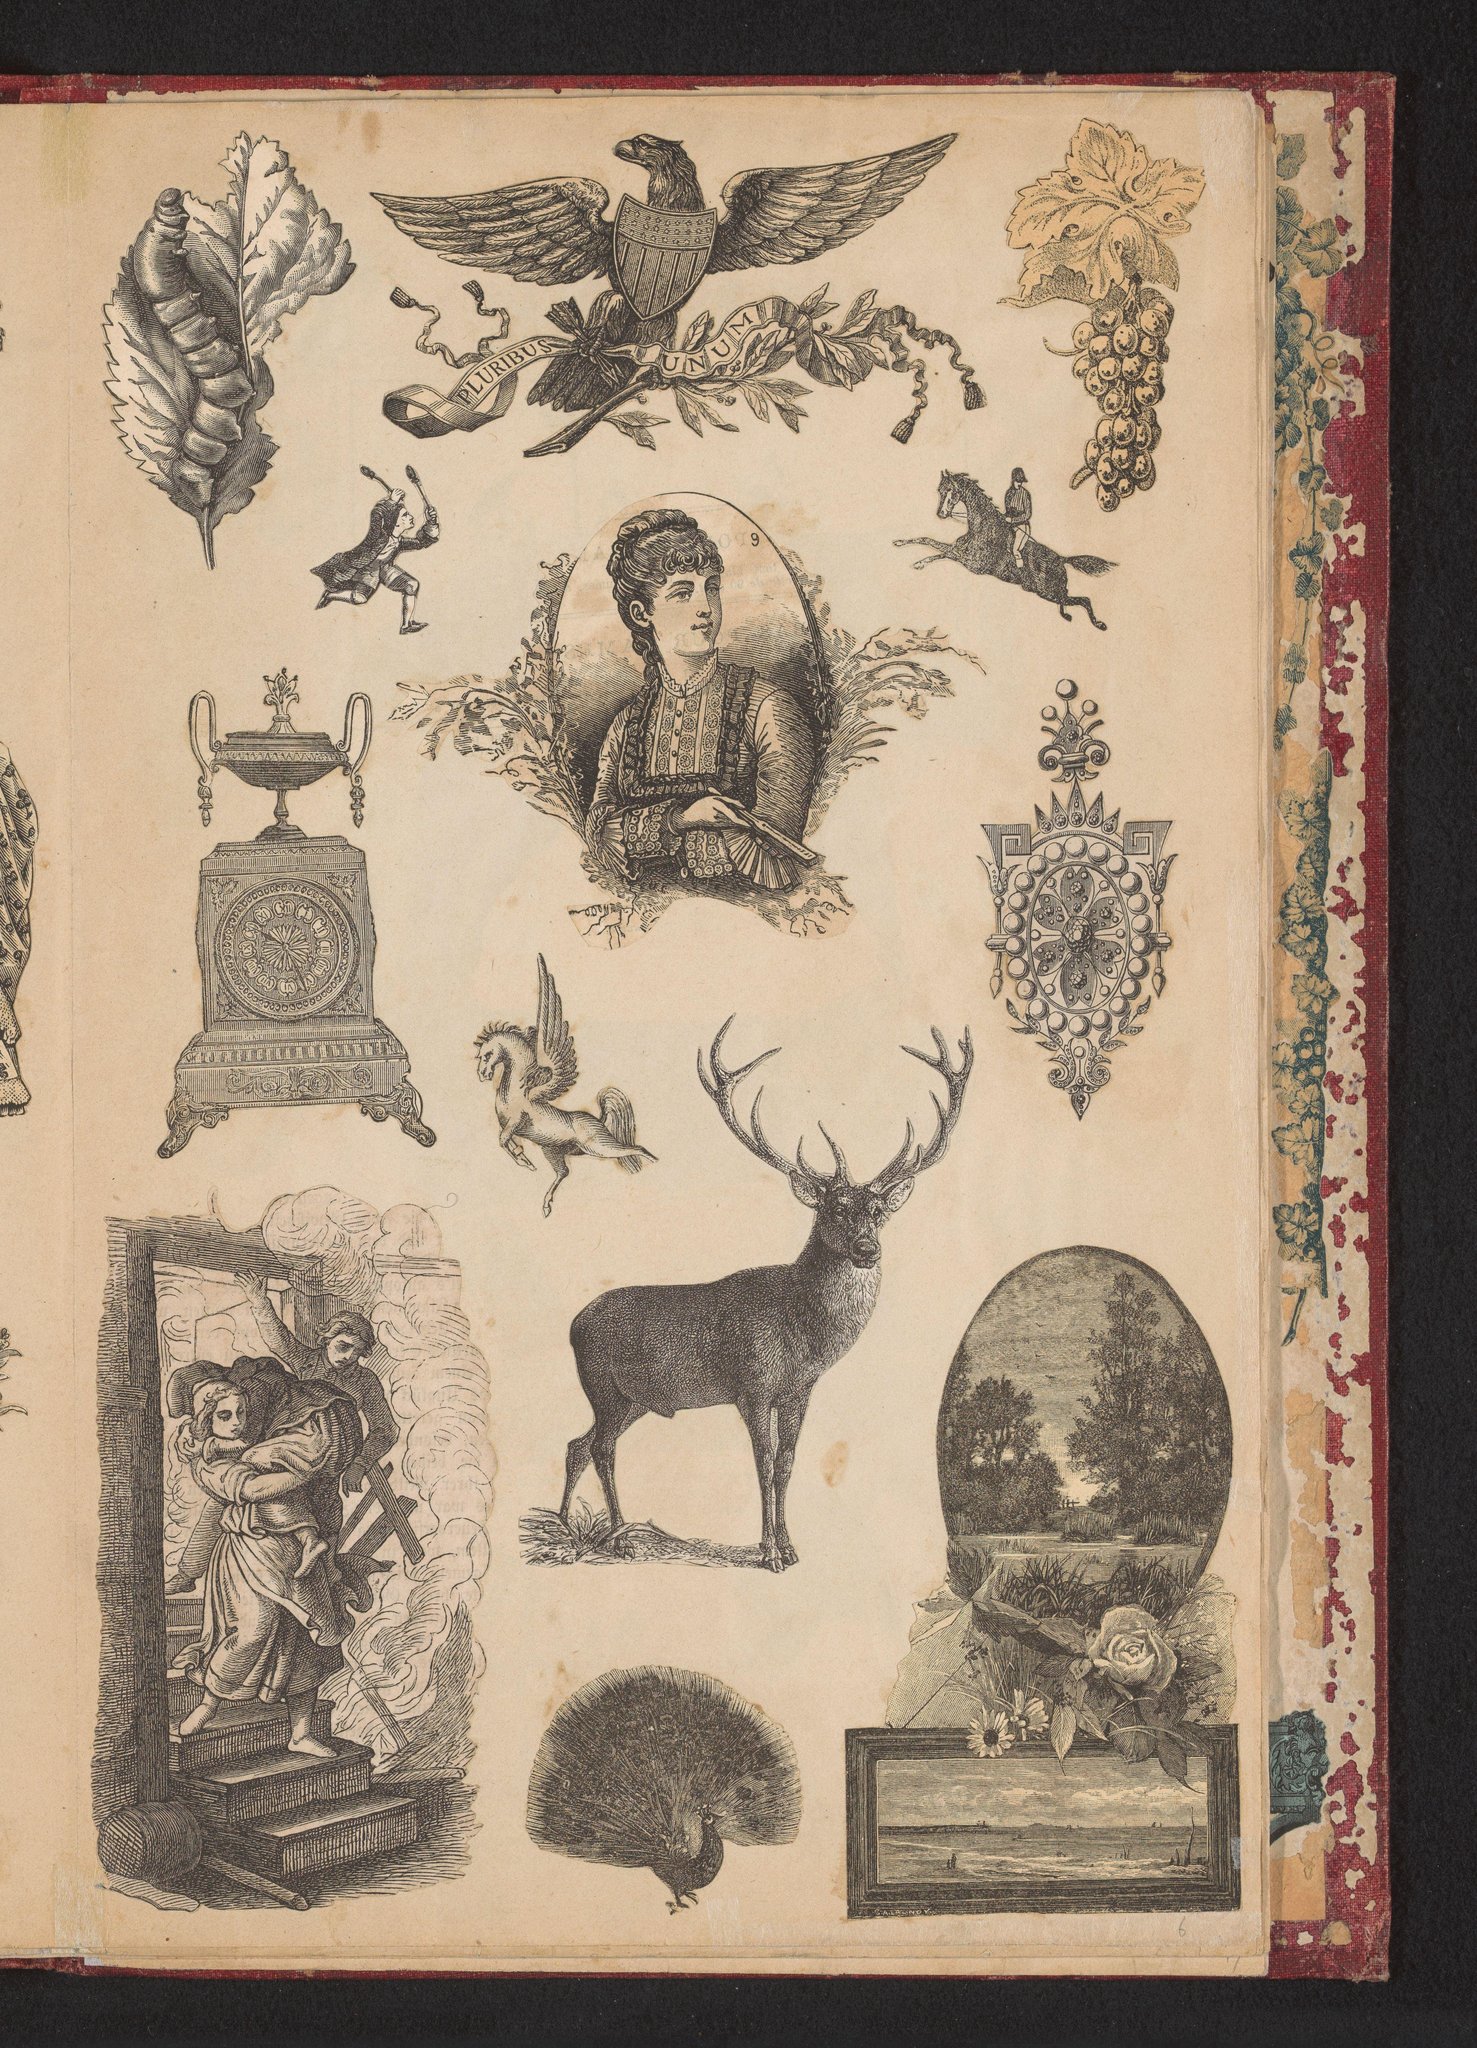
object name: collage visual work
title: Collage van uitgeknipte prenten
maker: Anonymous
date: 1870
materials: paper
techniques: engraving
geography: paris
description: Collage van uitgeknipte prenten. Onderdeel van een album met 18 bladen, aan beide zijden beplakt met uitgeknipte prenten, vermoedelijk afkomstig uit 19e-eeuwse tijdschiften.